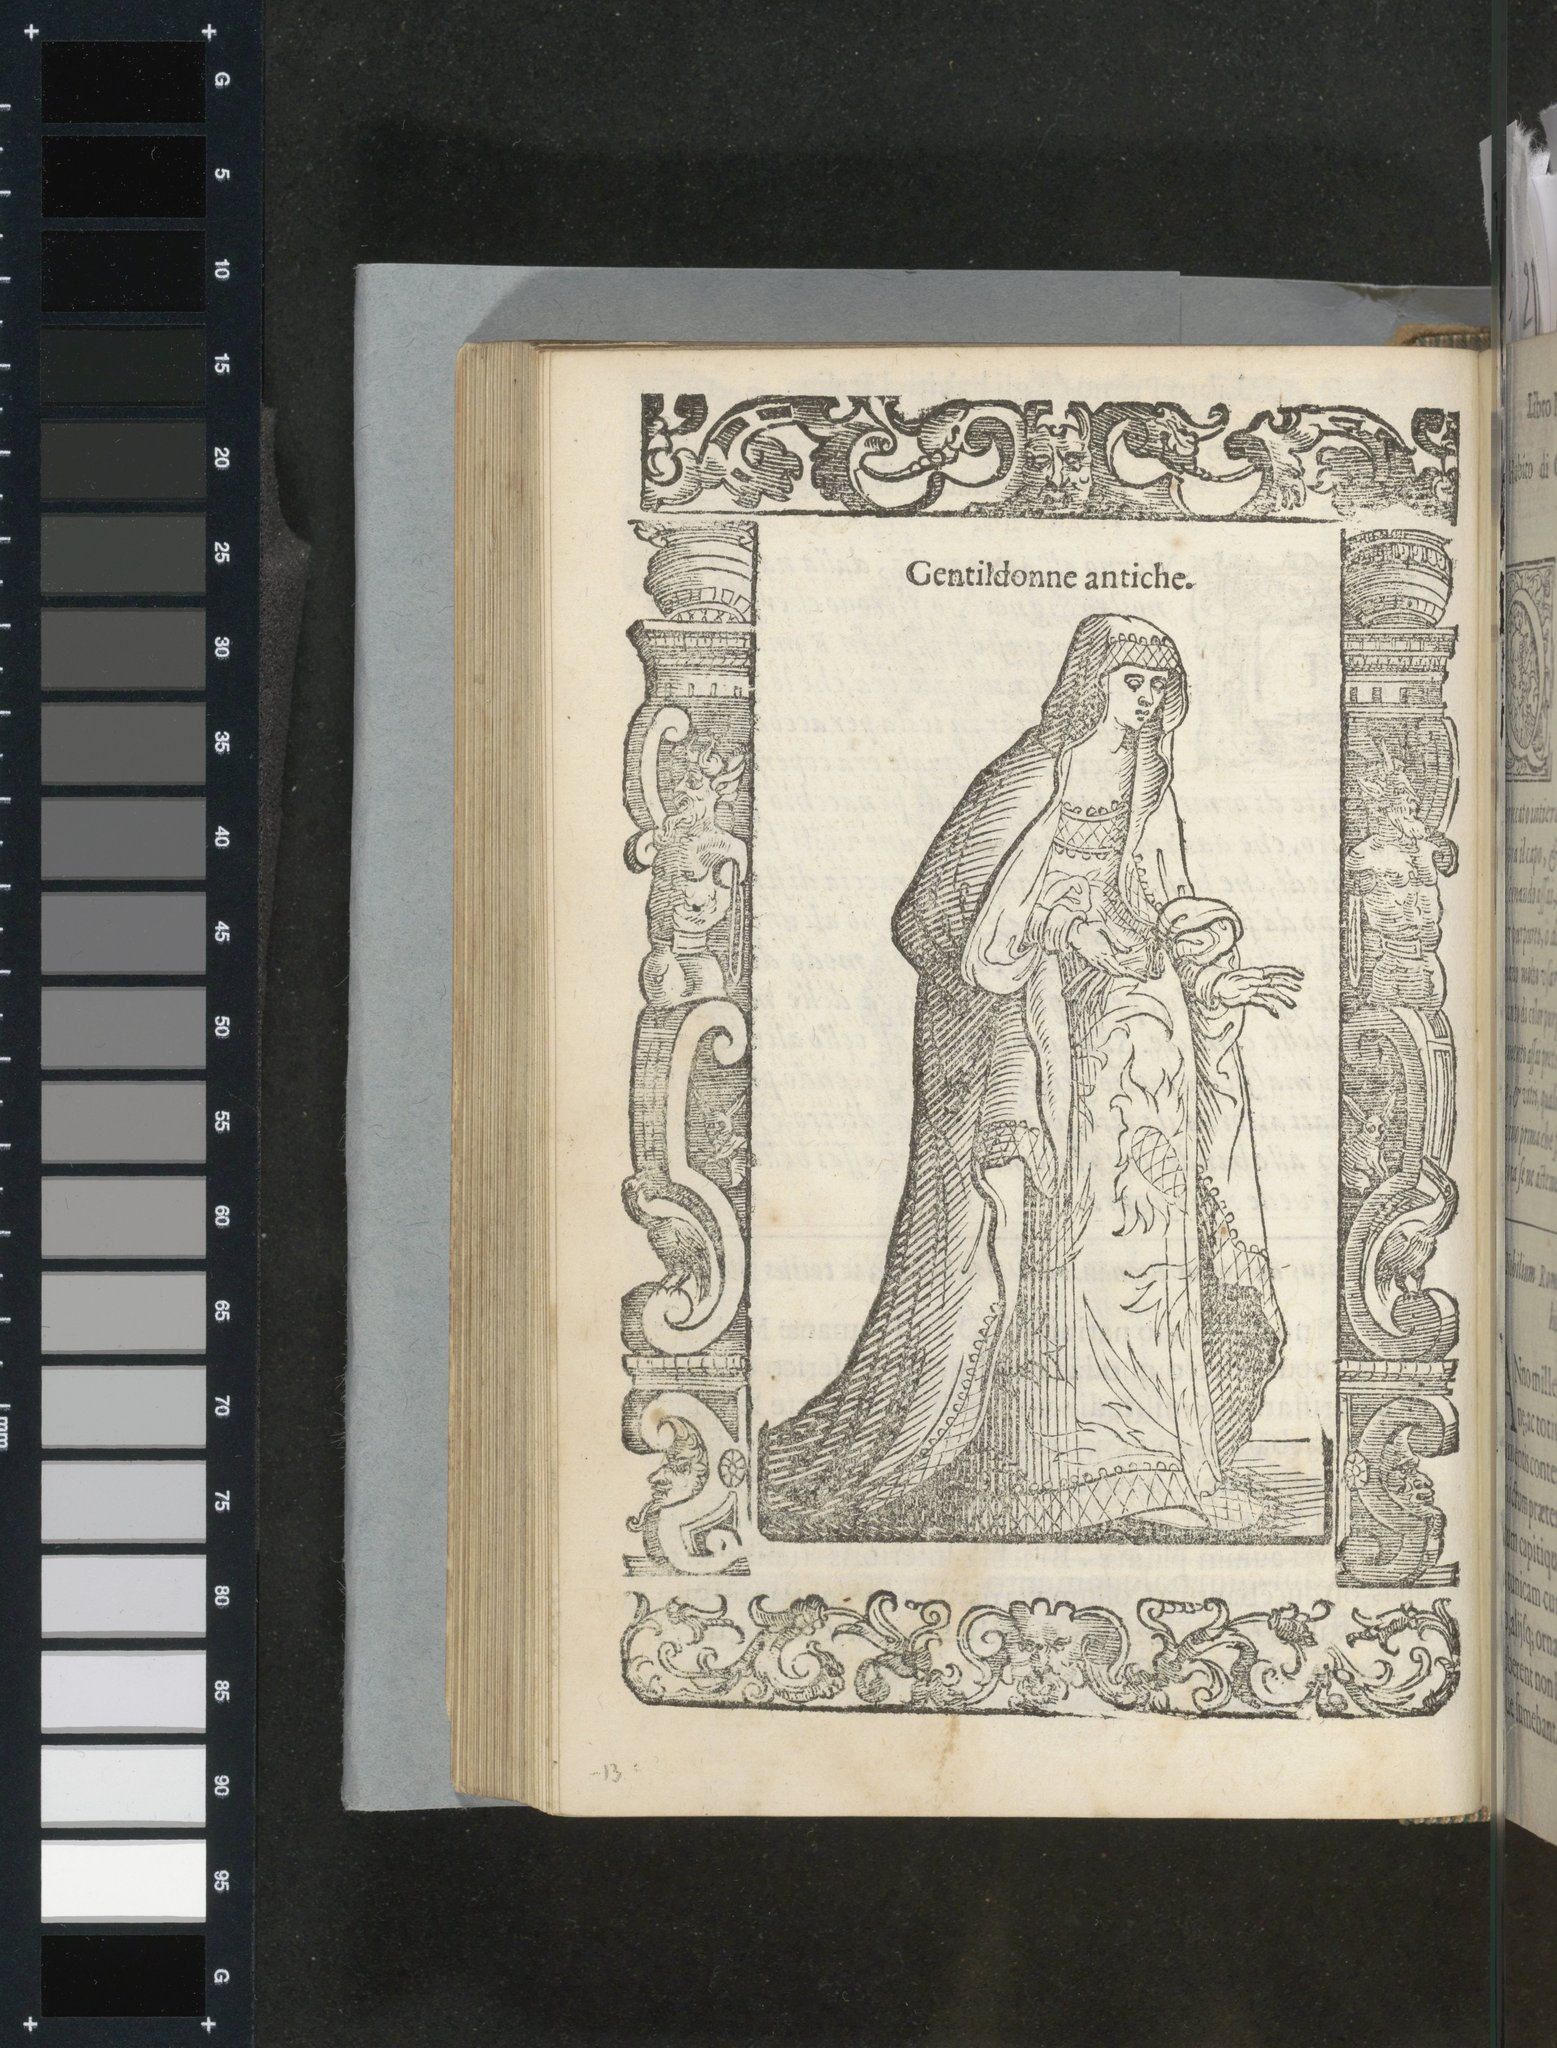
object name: costume print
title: Habiti antichi, et moderni di tutto il mondo : di nuovo accresciuti di molte figure : vestitus antiquorum, recentiorumque totius orbis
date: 1598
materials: paper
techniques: woodcut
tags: cape (+ women's clothes), parasol, sunshade (+ women's clothes)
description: Romeinse adellijke dame in een zijden geborduurd onderkleed waarover een mantel die over het hoofd is geslagen. Volgens de tekst van Vecellio werd deze kleding, behalve in Rome, rond 1300 overal in Italië gedragen. In ornamentrand.